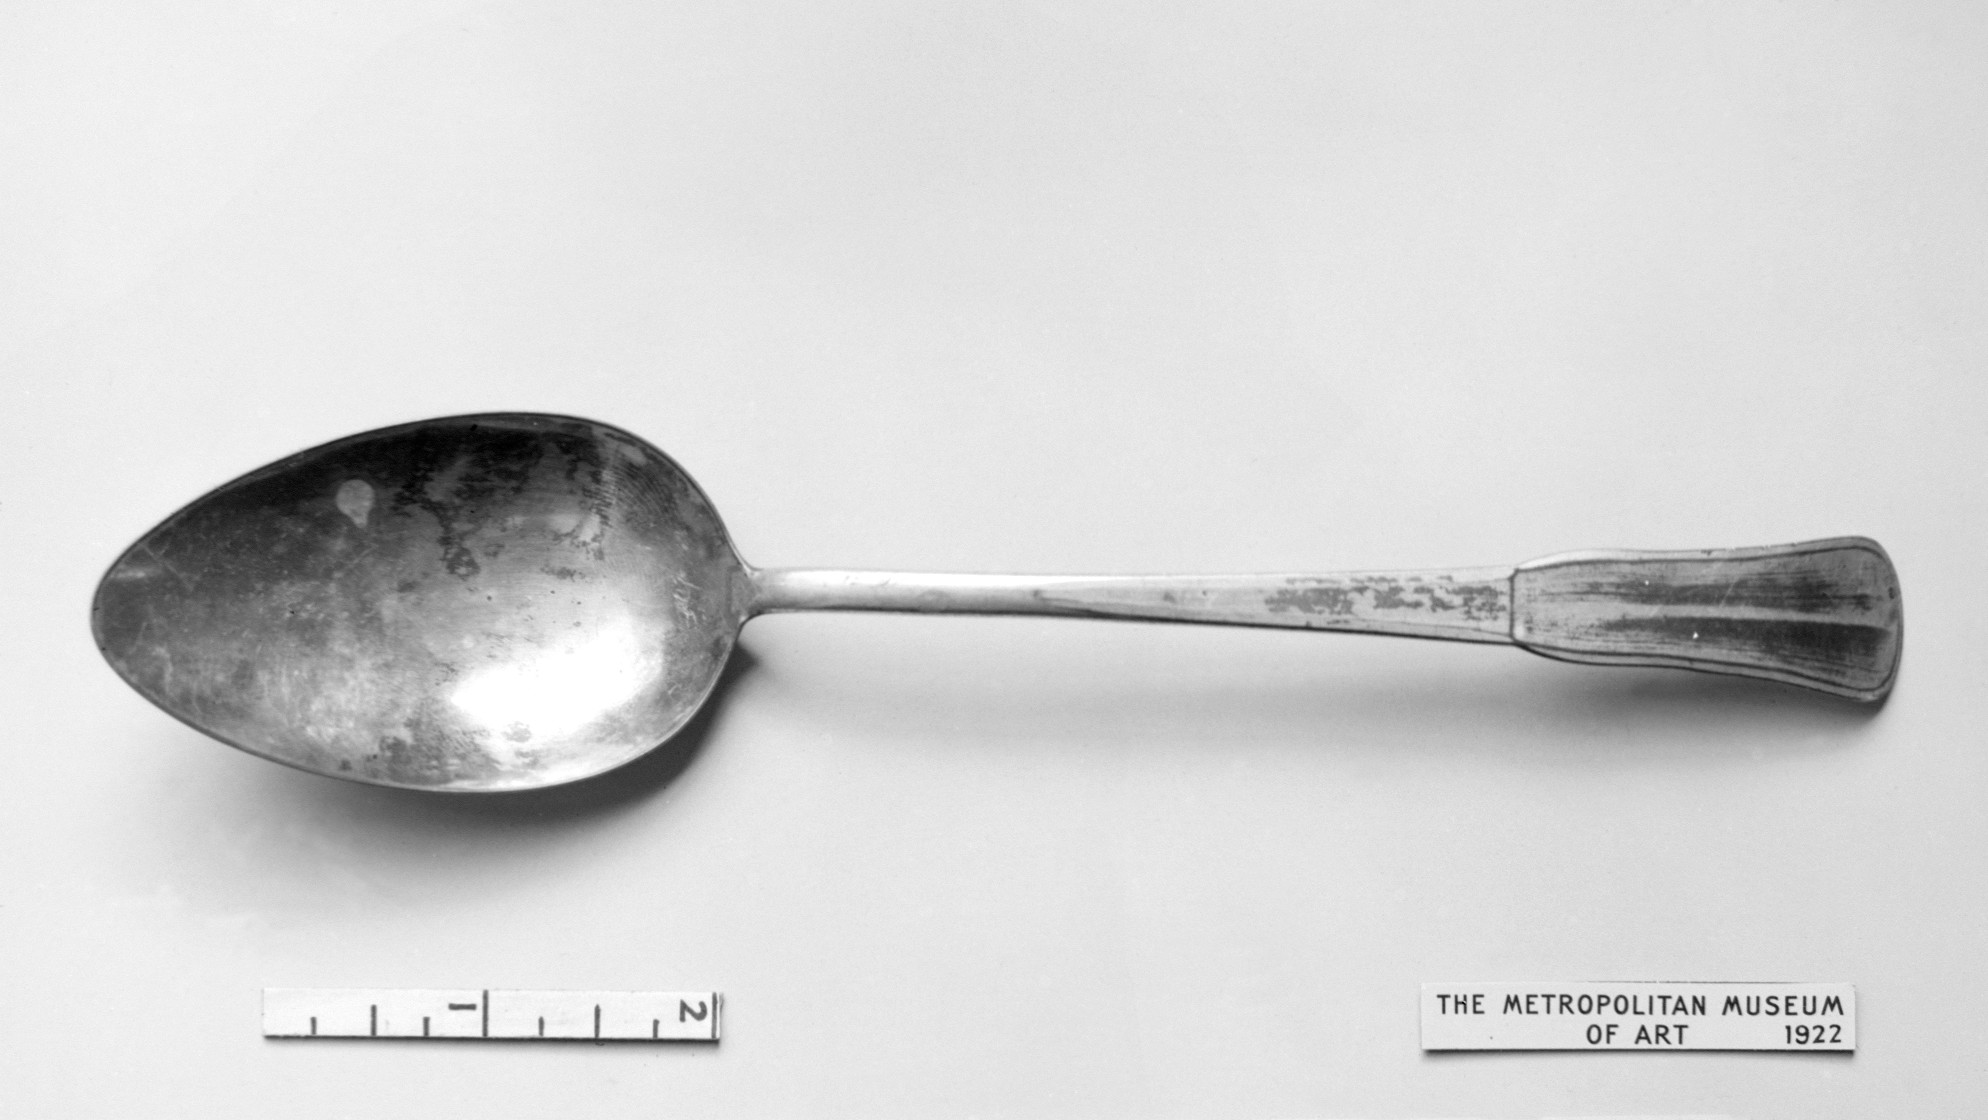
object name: tablespoon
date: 1767-1833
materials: metal